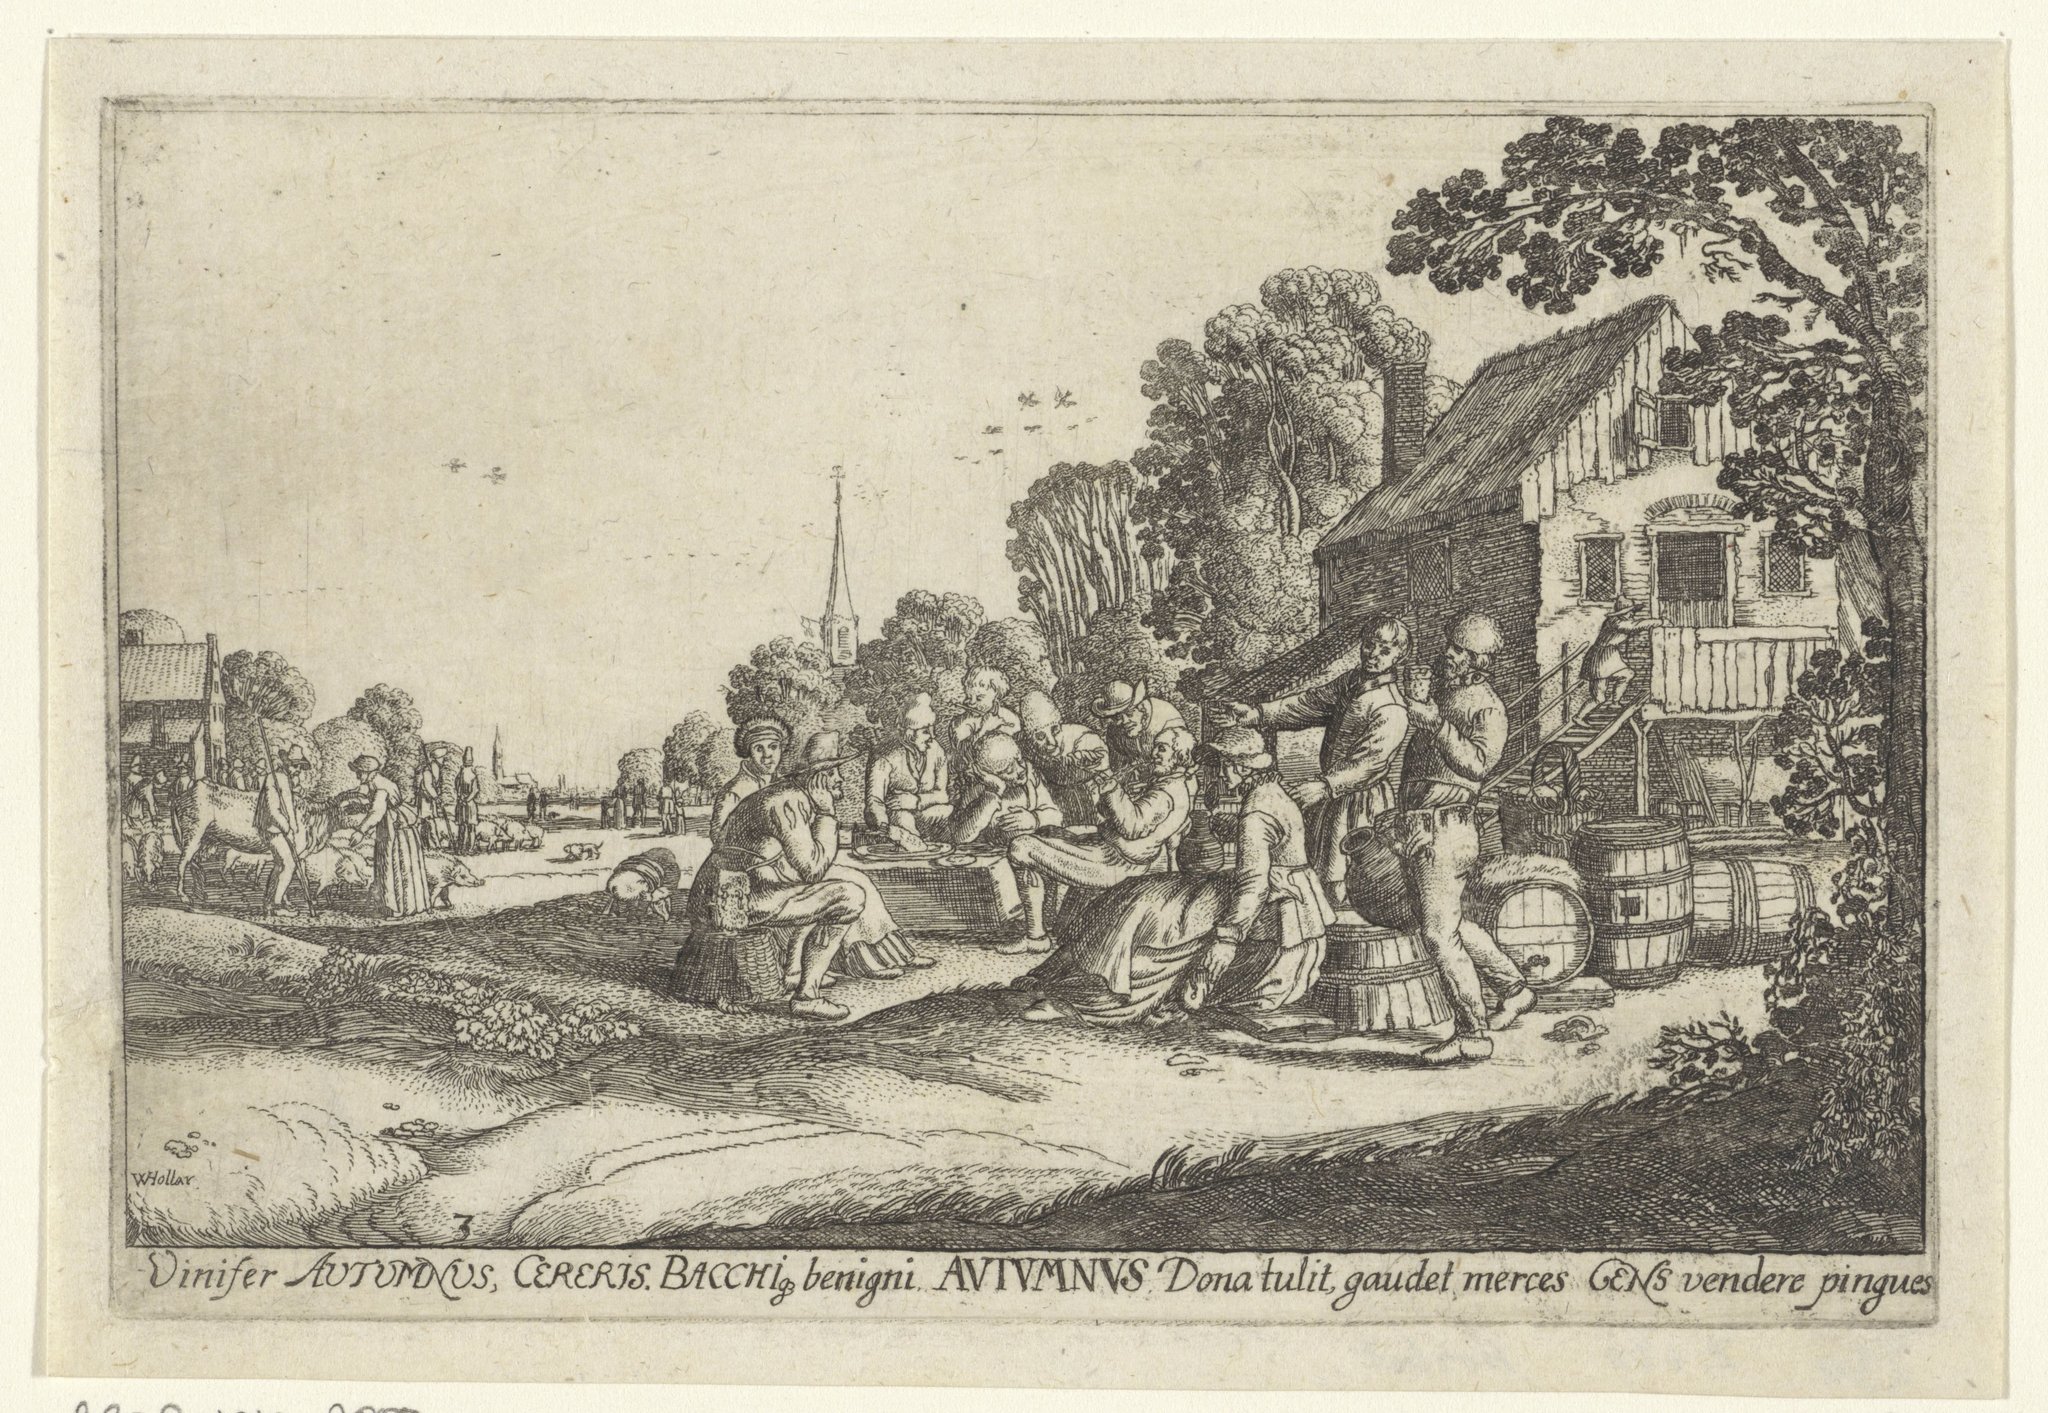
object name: print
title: Autumnus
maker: wenceslaus hollar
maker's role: draughtsman, print maker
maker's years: 1607-1677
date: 1629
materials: paper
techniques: etching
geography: germany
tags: farmers, autumn ~ human activities (the four seasons of the year), village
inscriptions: collector's mark: Lugt 567, collector's mark: Lugt 2233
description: Dorpsgezicht met boeren zittend rond een tafel.